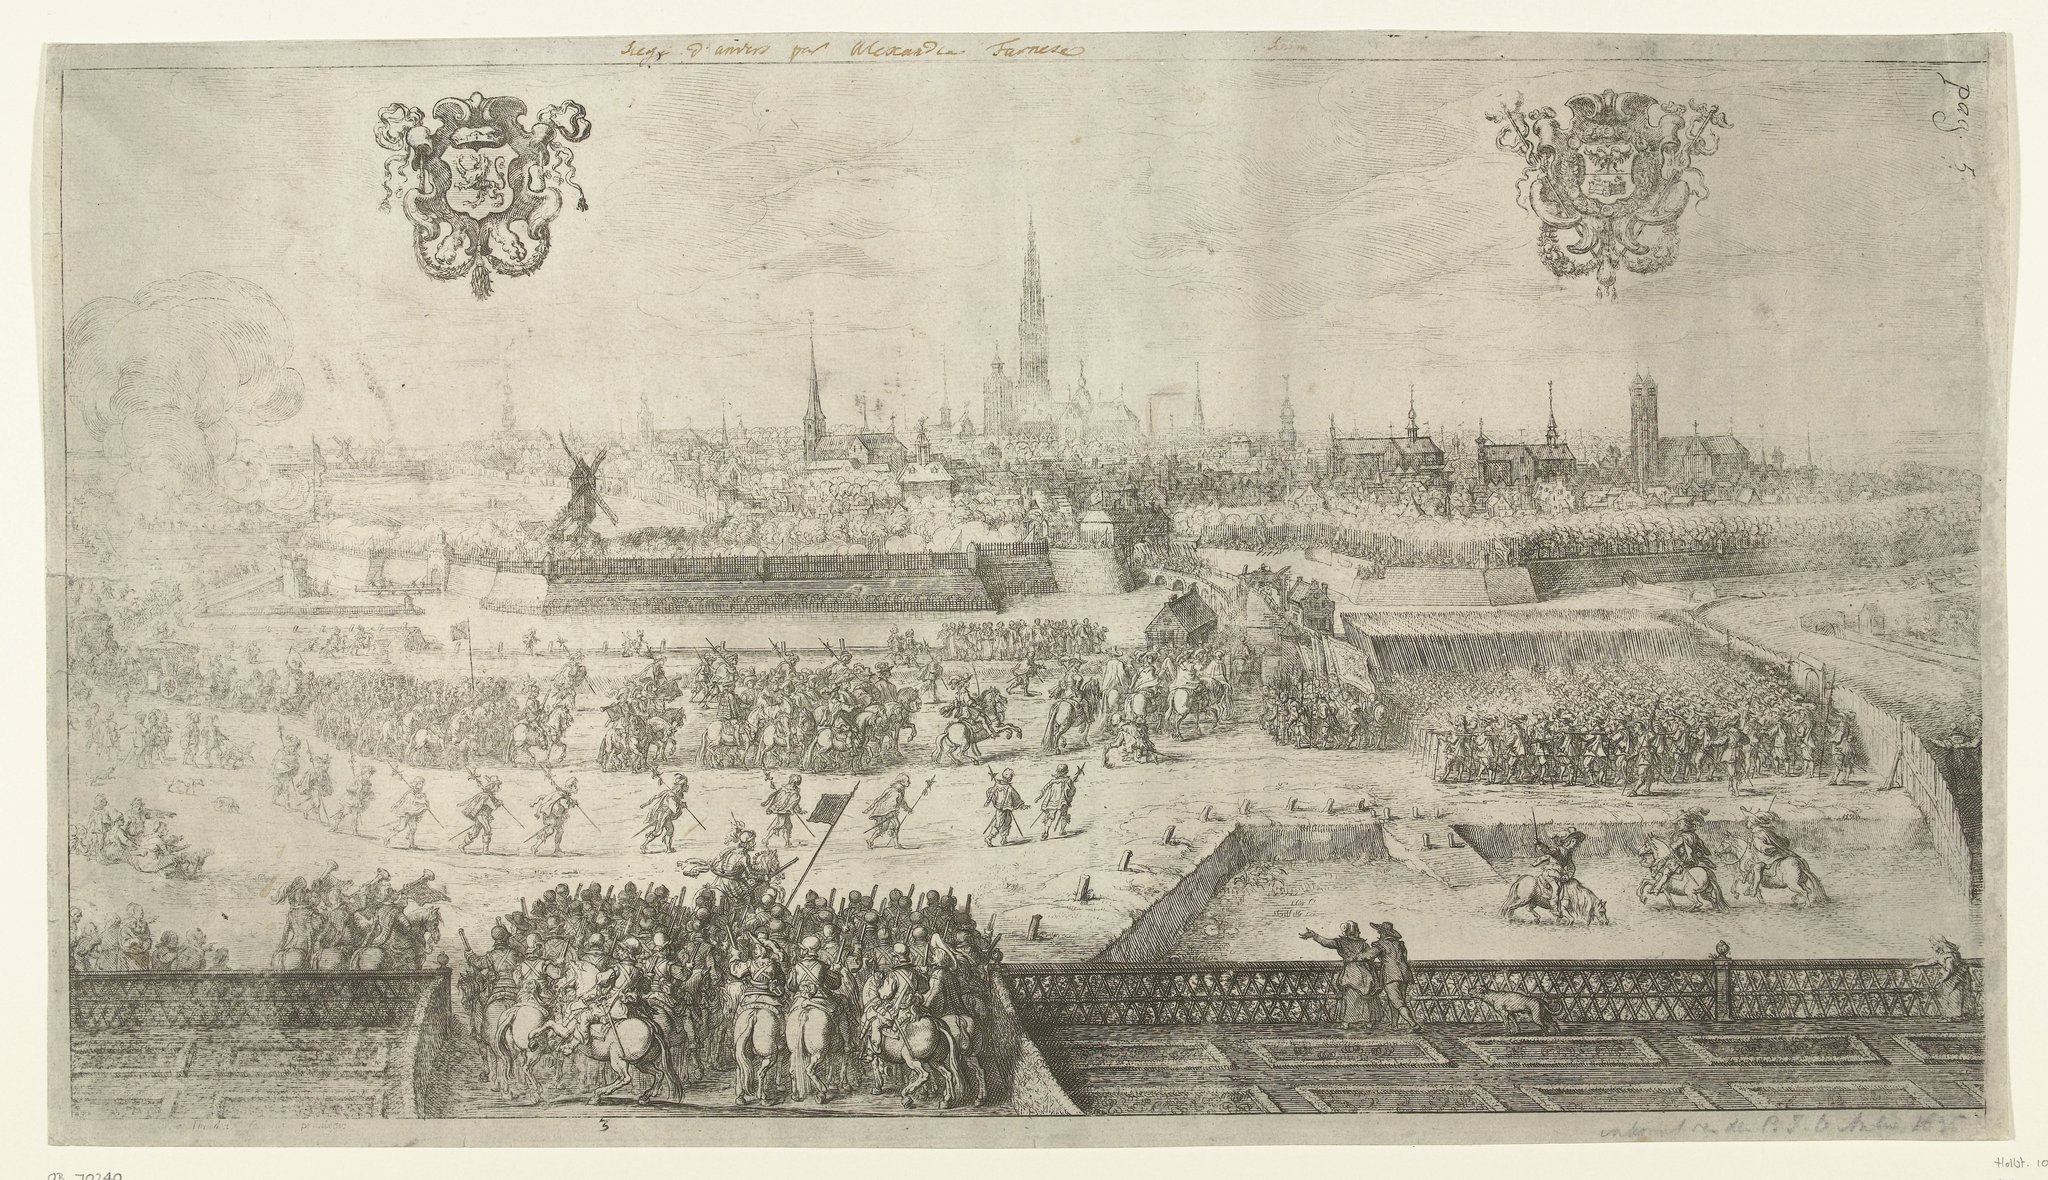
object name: print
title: Aankomst van de stoet bij de stadspoort van Antwerpen; intocht van Ferdinand te Antwerpen in 1635 (nr. 3)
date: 1639-1641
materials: paper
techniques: engraving, etching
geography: brussels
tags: landvoogd der zuidelijke nederlanden ferdinand van oostenrijk, triumphal entry and public reception, pageant, 'entrée solennelle', 'joyeuse entrée', antwerp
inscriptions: inscription: ‘Siege d'anvers par Alexandre Farnese’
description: Aankomst van de stoet bij de stadspoort van Antwerpen. Op de voorgrond een groep ruiters, rechts staat een leger van schutters en piekeniers opgesteld. In de lucht de wapens van Brabant en Antwerpen. Gemerkt rechtsboven: pag. 5. Blad nr. 3 in een geheel van 43 platen die de uitgave van de beschrijving van de intocht van de Kardinaal Infant Ferdinand van Oostenrijk te Antwerpen op 17 april 1635 als de nieuwe landvoogd voor de Spaanse Nederlanden illustreren.